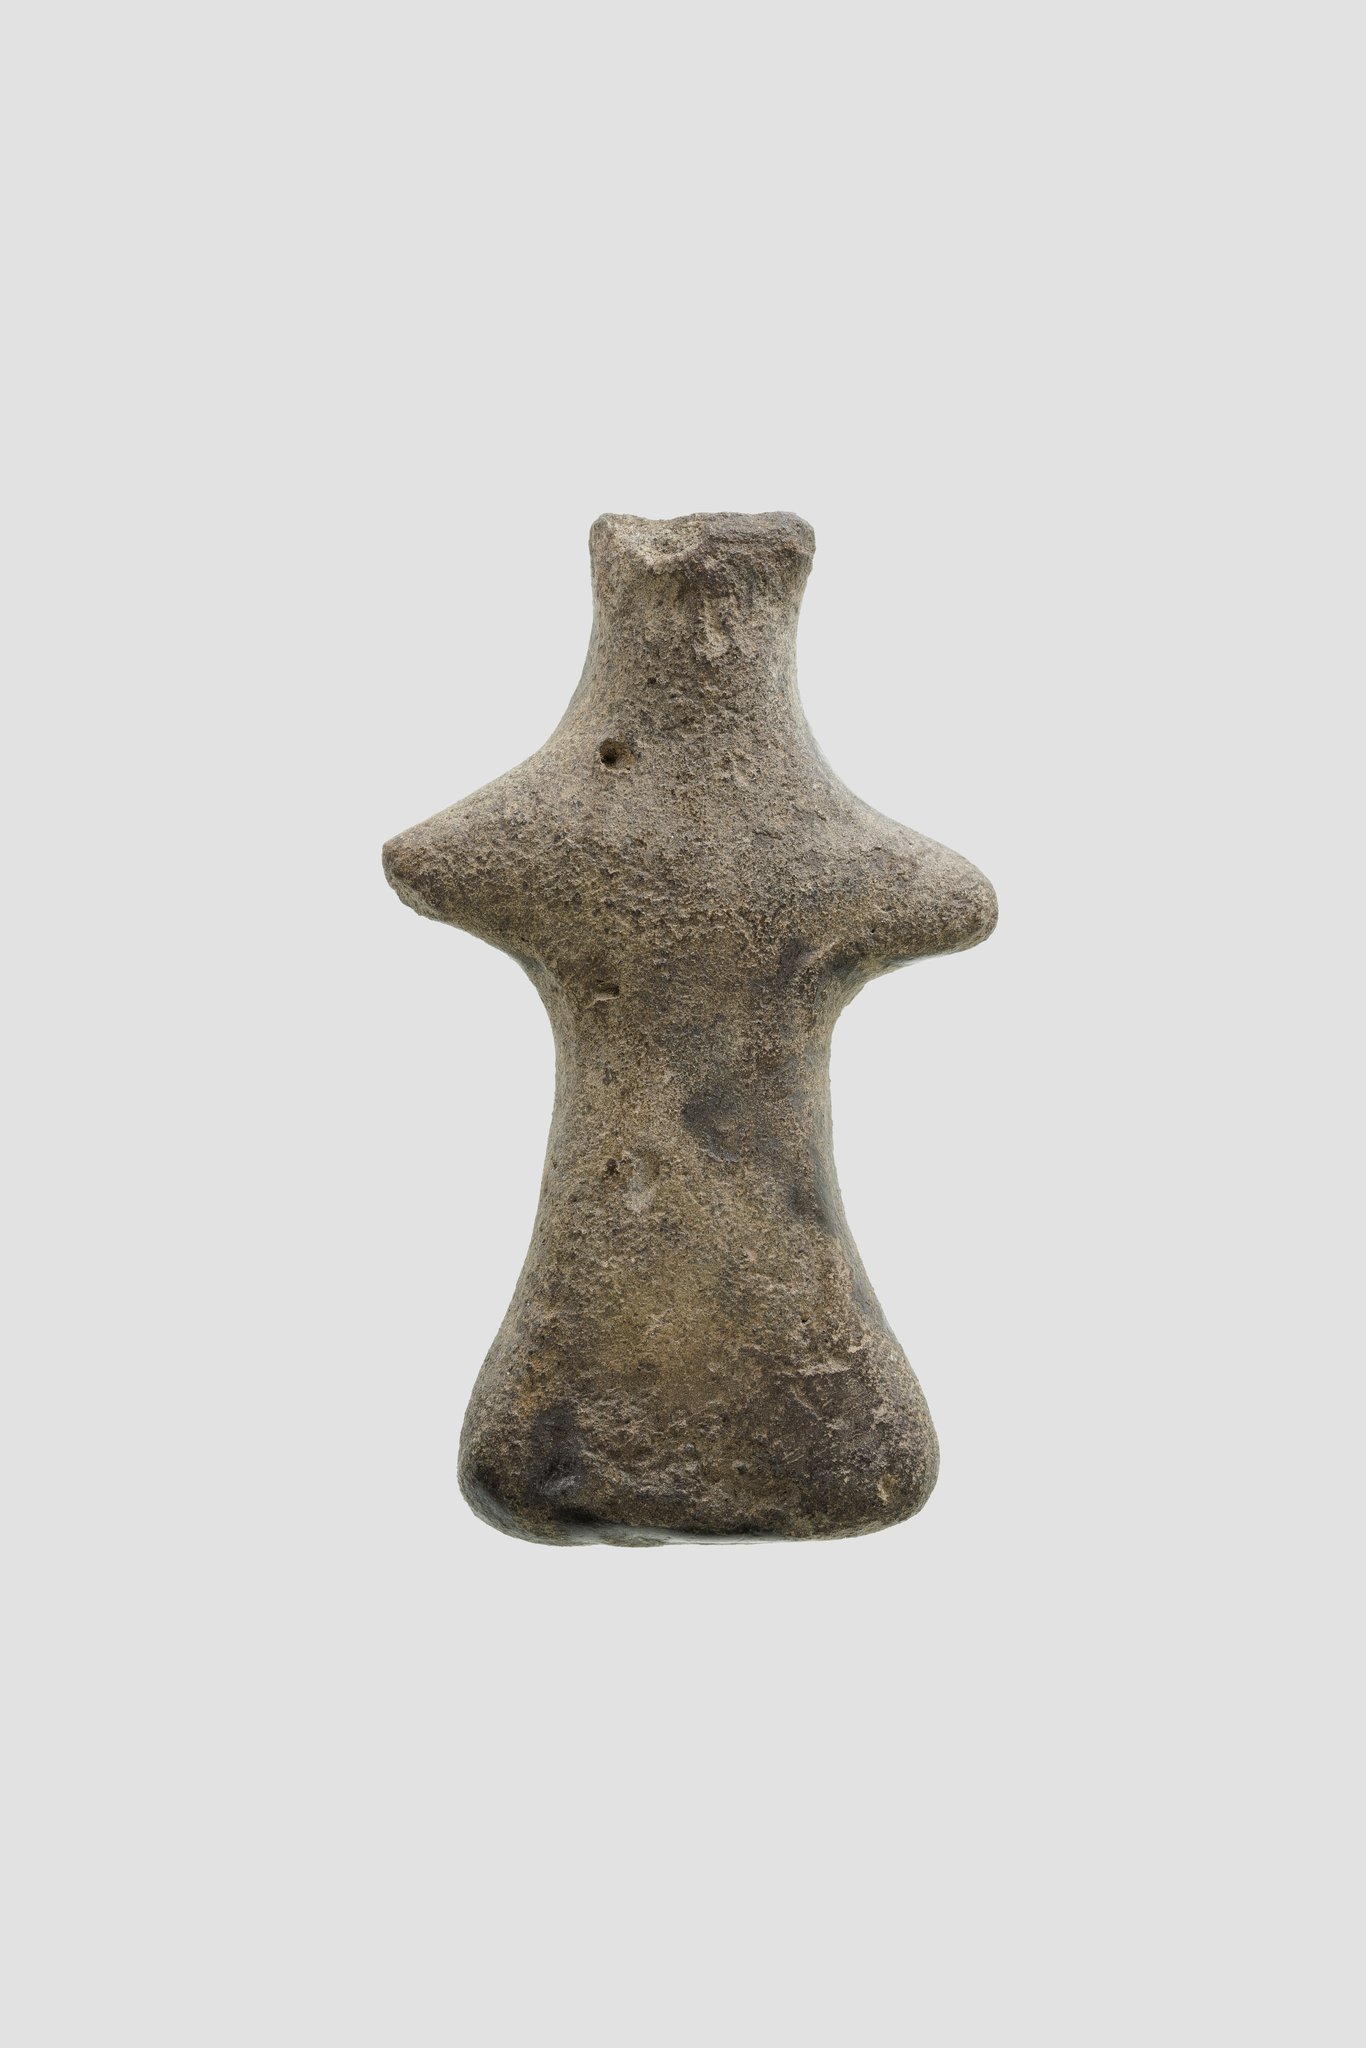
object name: abstracted human figure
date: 1981-1640 BCE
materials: clay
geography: egypt